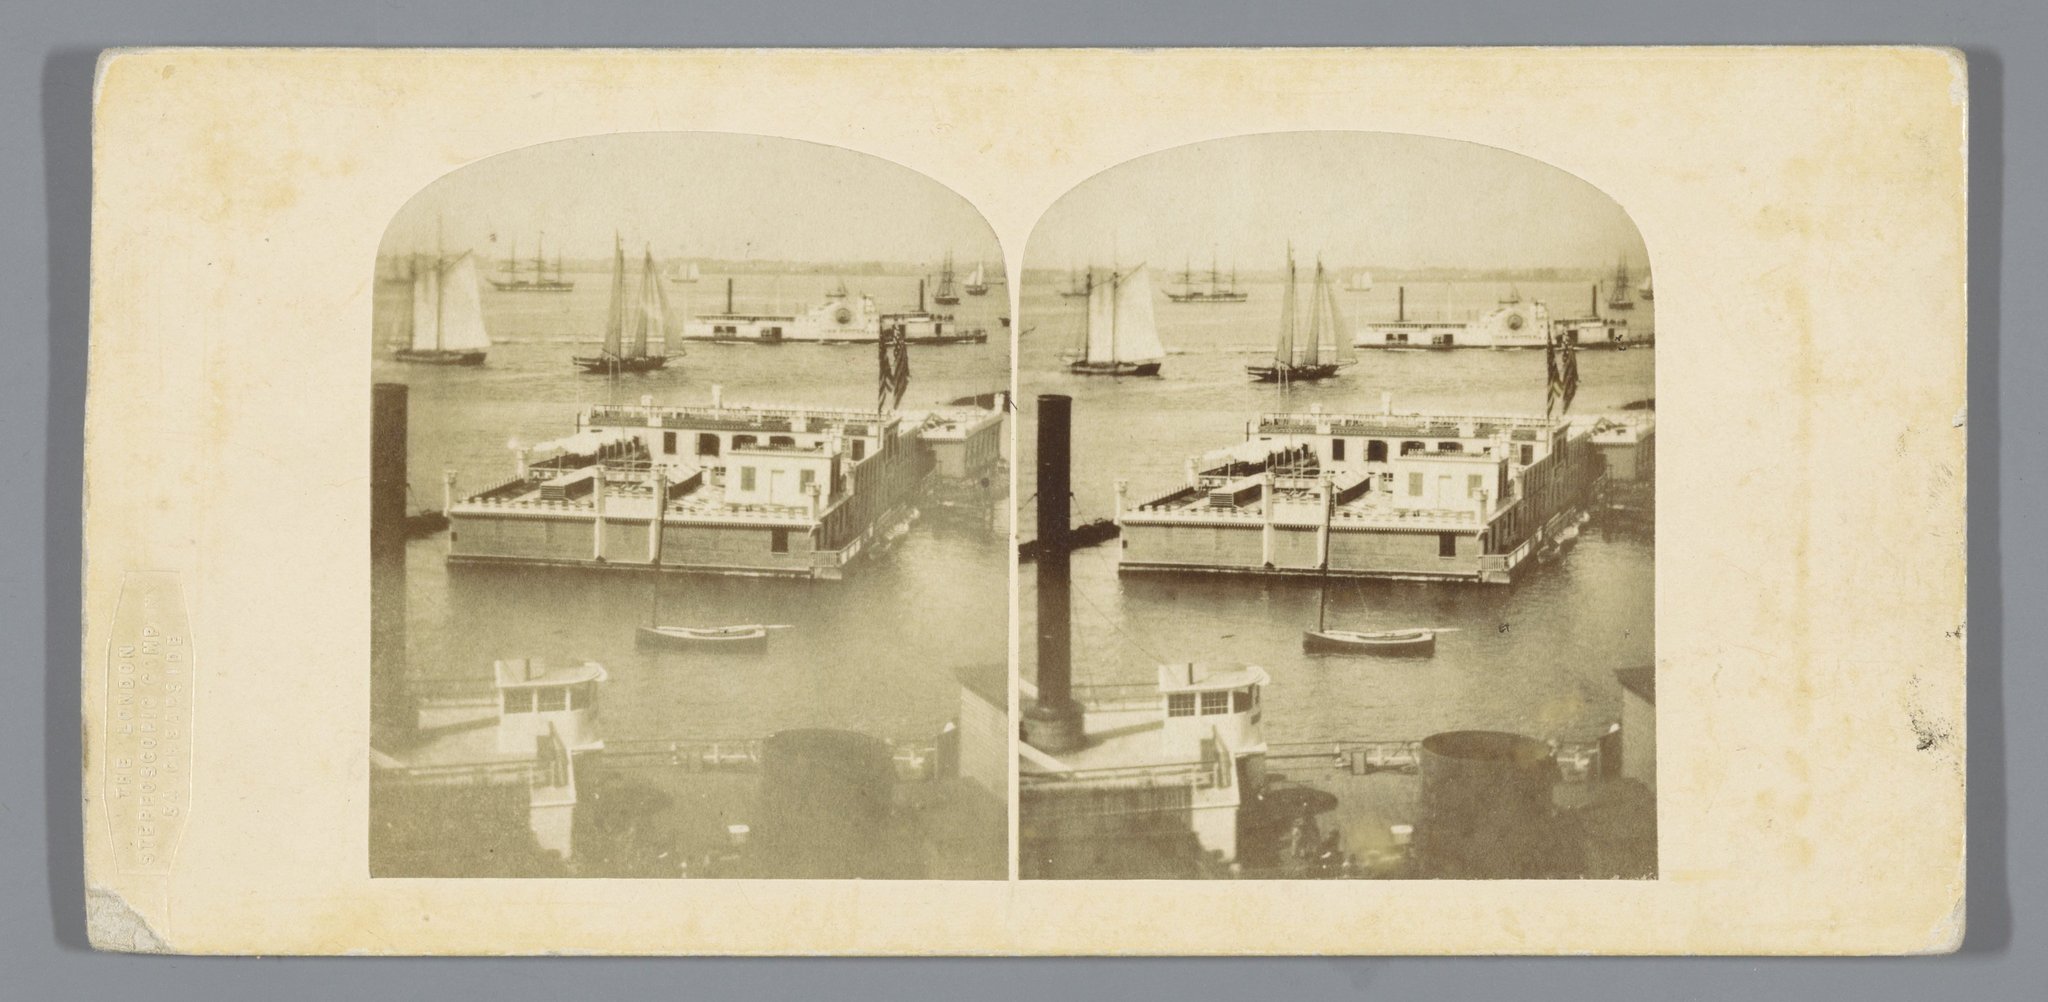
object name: stereograph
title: View from the Barge Office, New York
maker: william england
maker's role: fotograaf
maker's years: 1816-1896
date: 1859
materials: cardboard, paper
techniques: albumen print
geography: new york city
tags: gulf, bay, ships (in general) - cc - more than one ship, new york (city)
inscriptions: : ‘The accompanying instantaneous (...) in the world.’